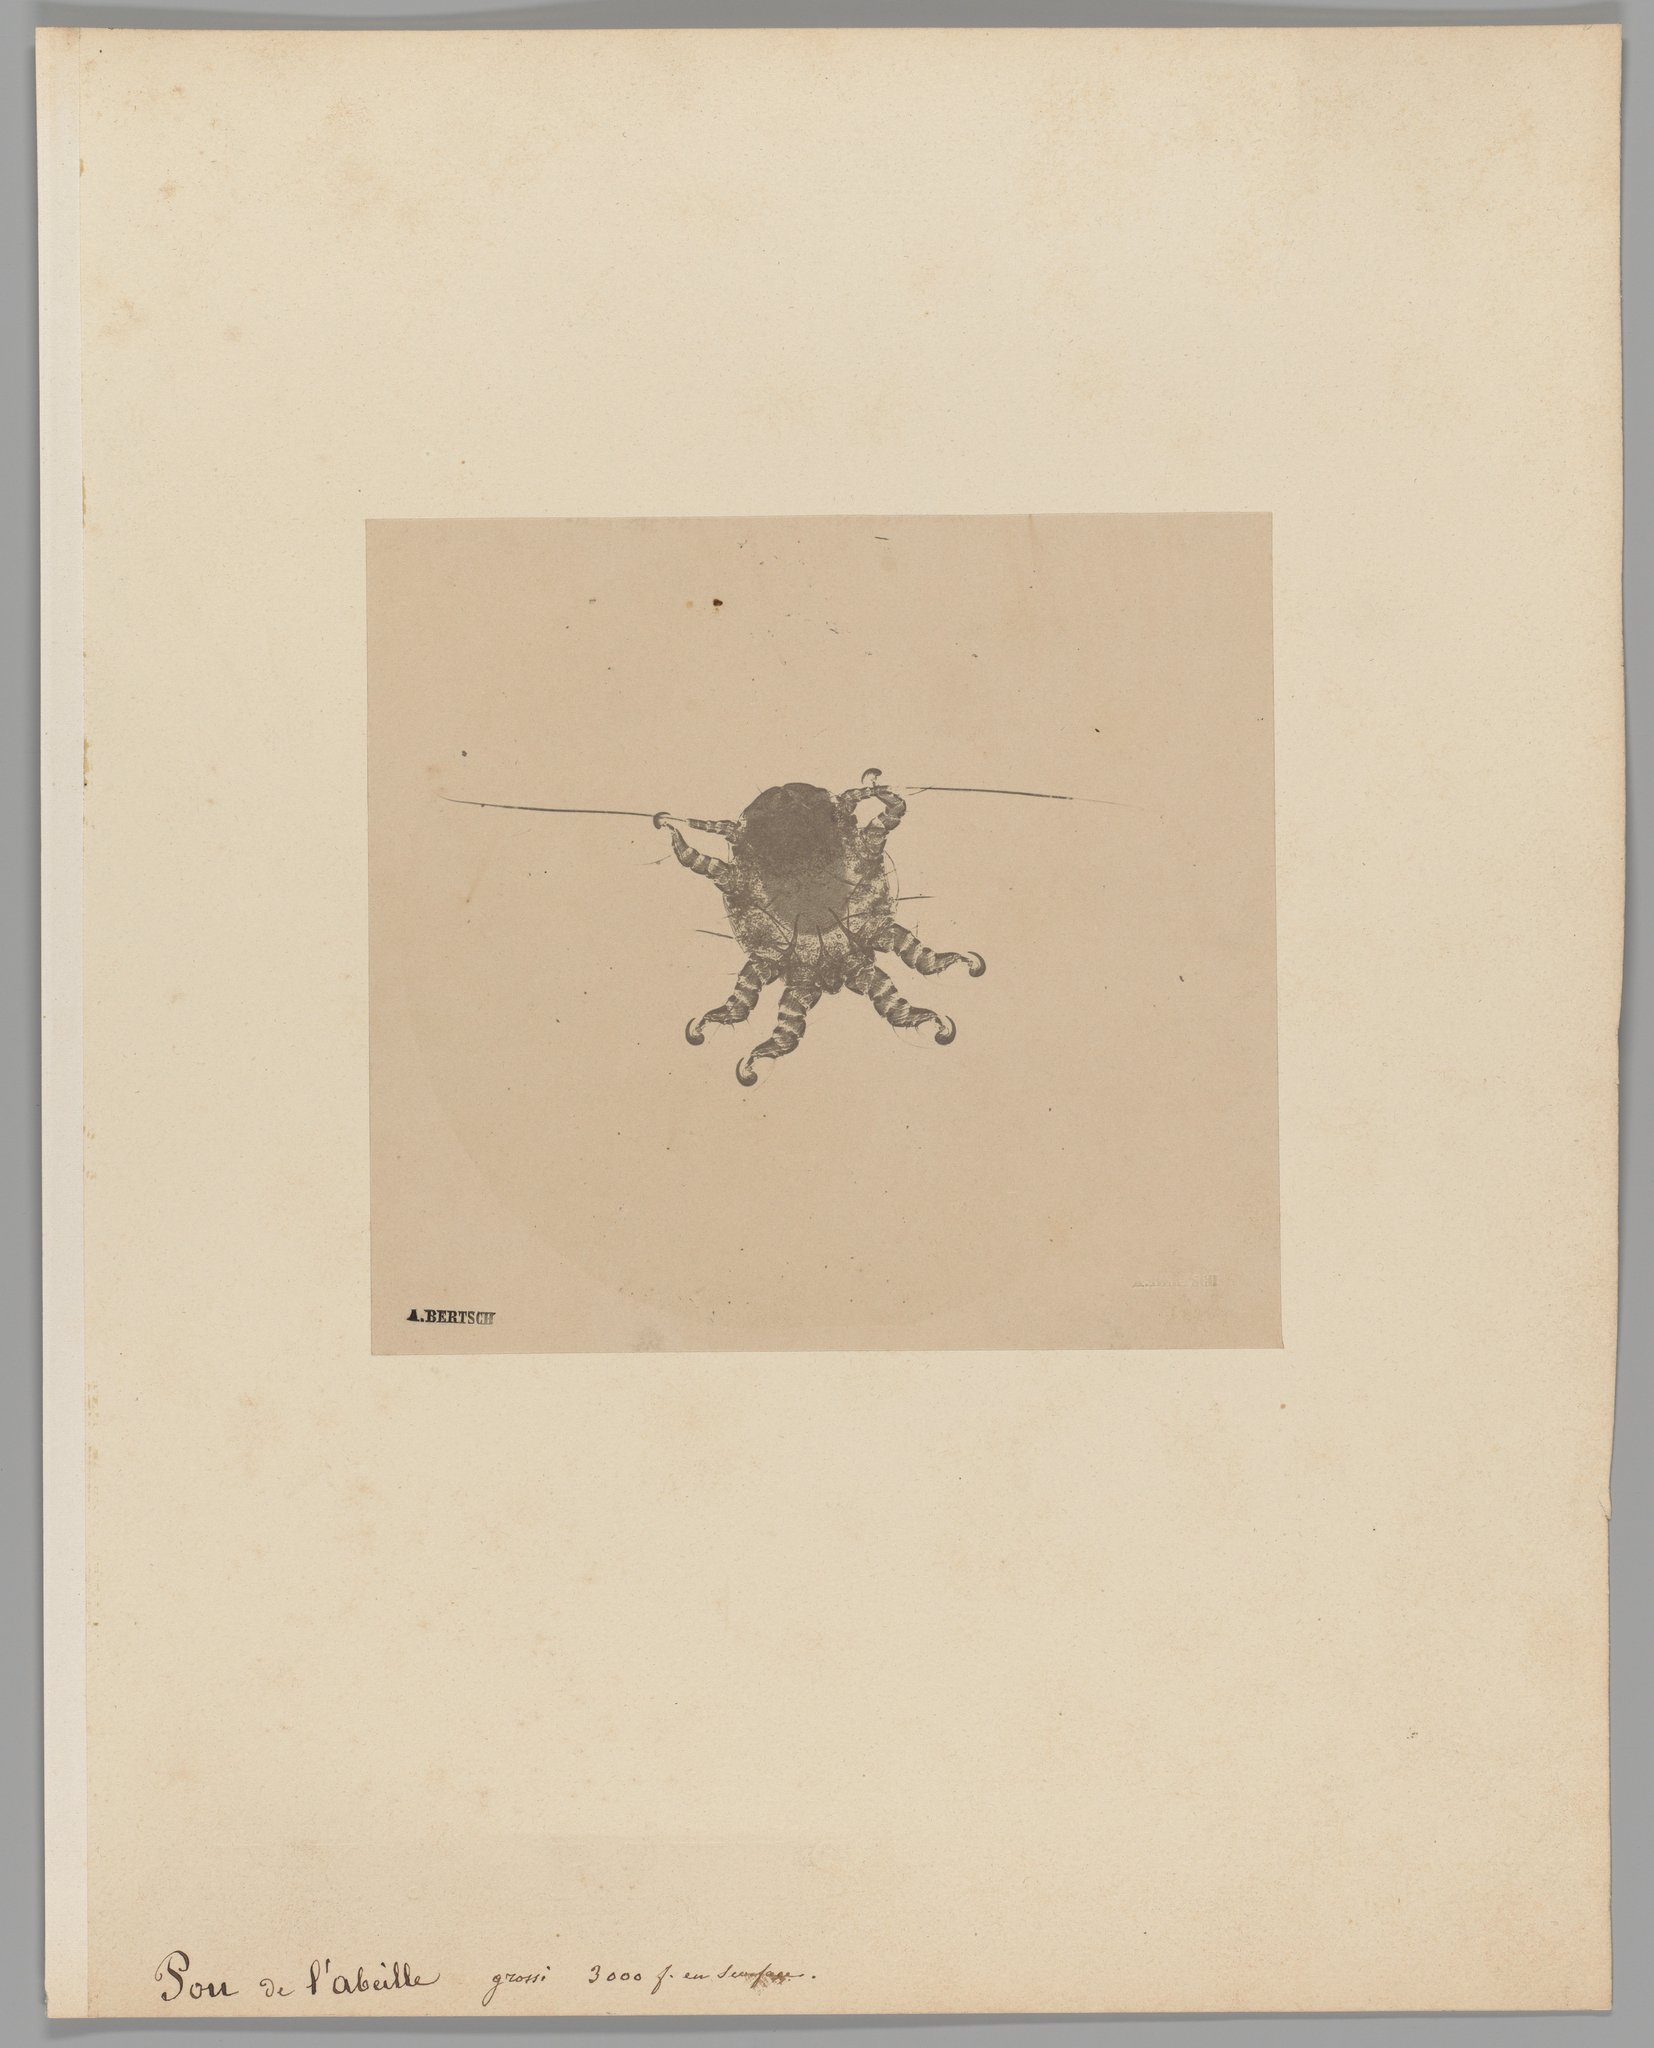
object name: photograph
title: Pou du l’abeille [Bee Stinger]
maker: auguste-adolphe bertsch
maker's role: artist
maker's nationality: french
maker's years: 1813-1871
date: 1853-1857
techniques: salted paper print